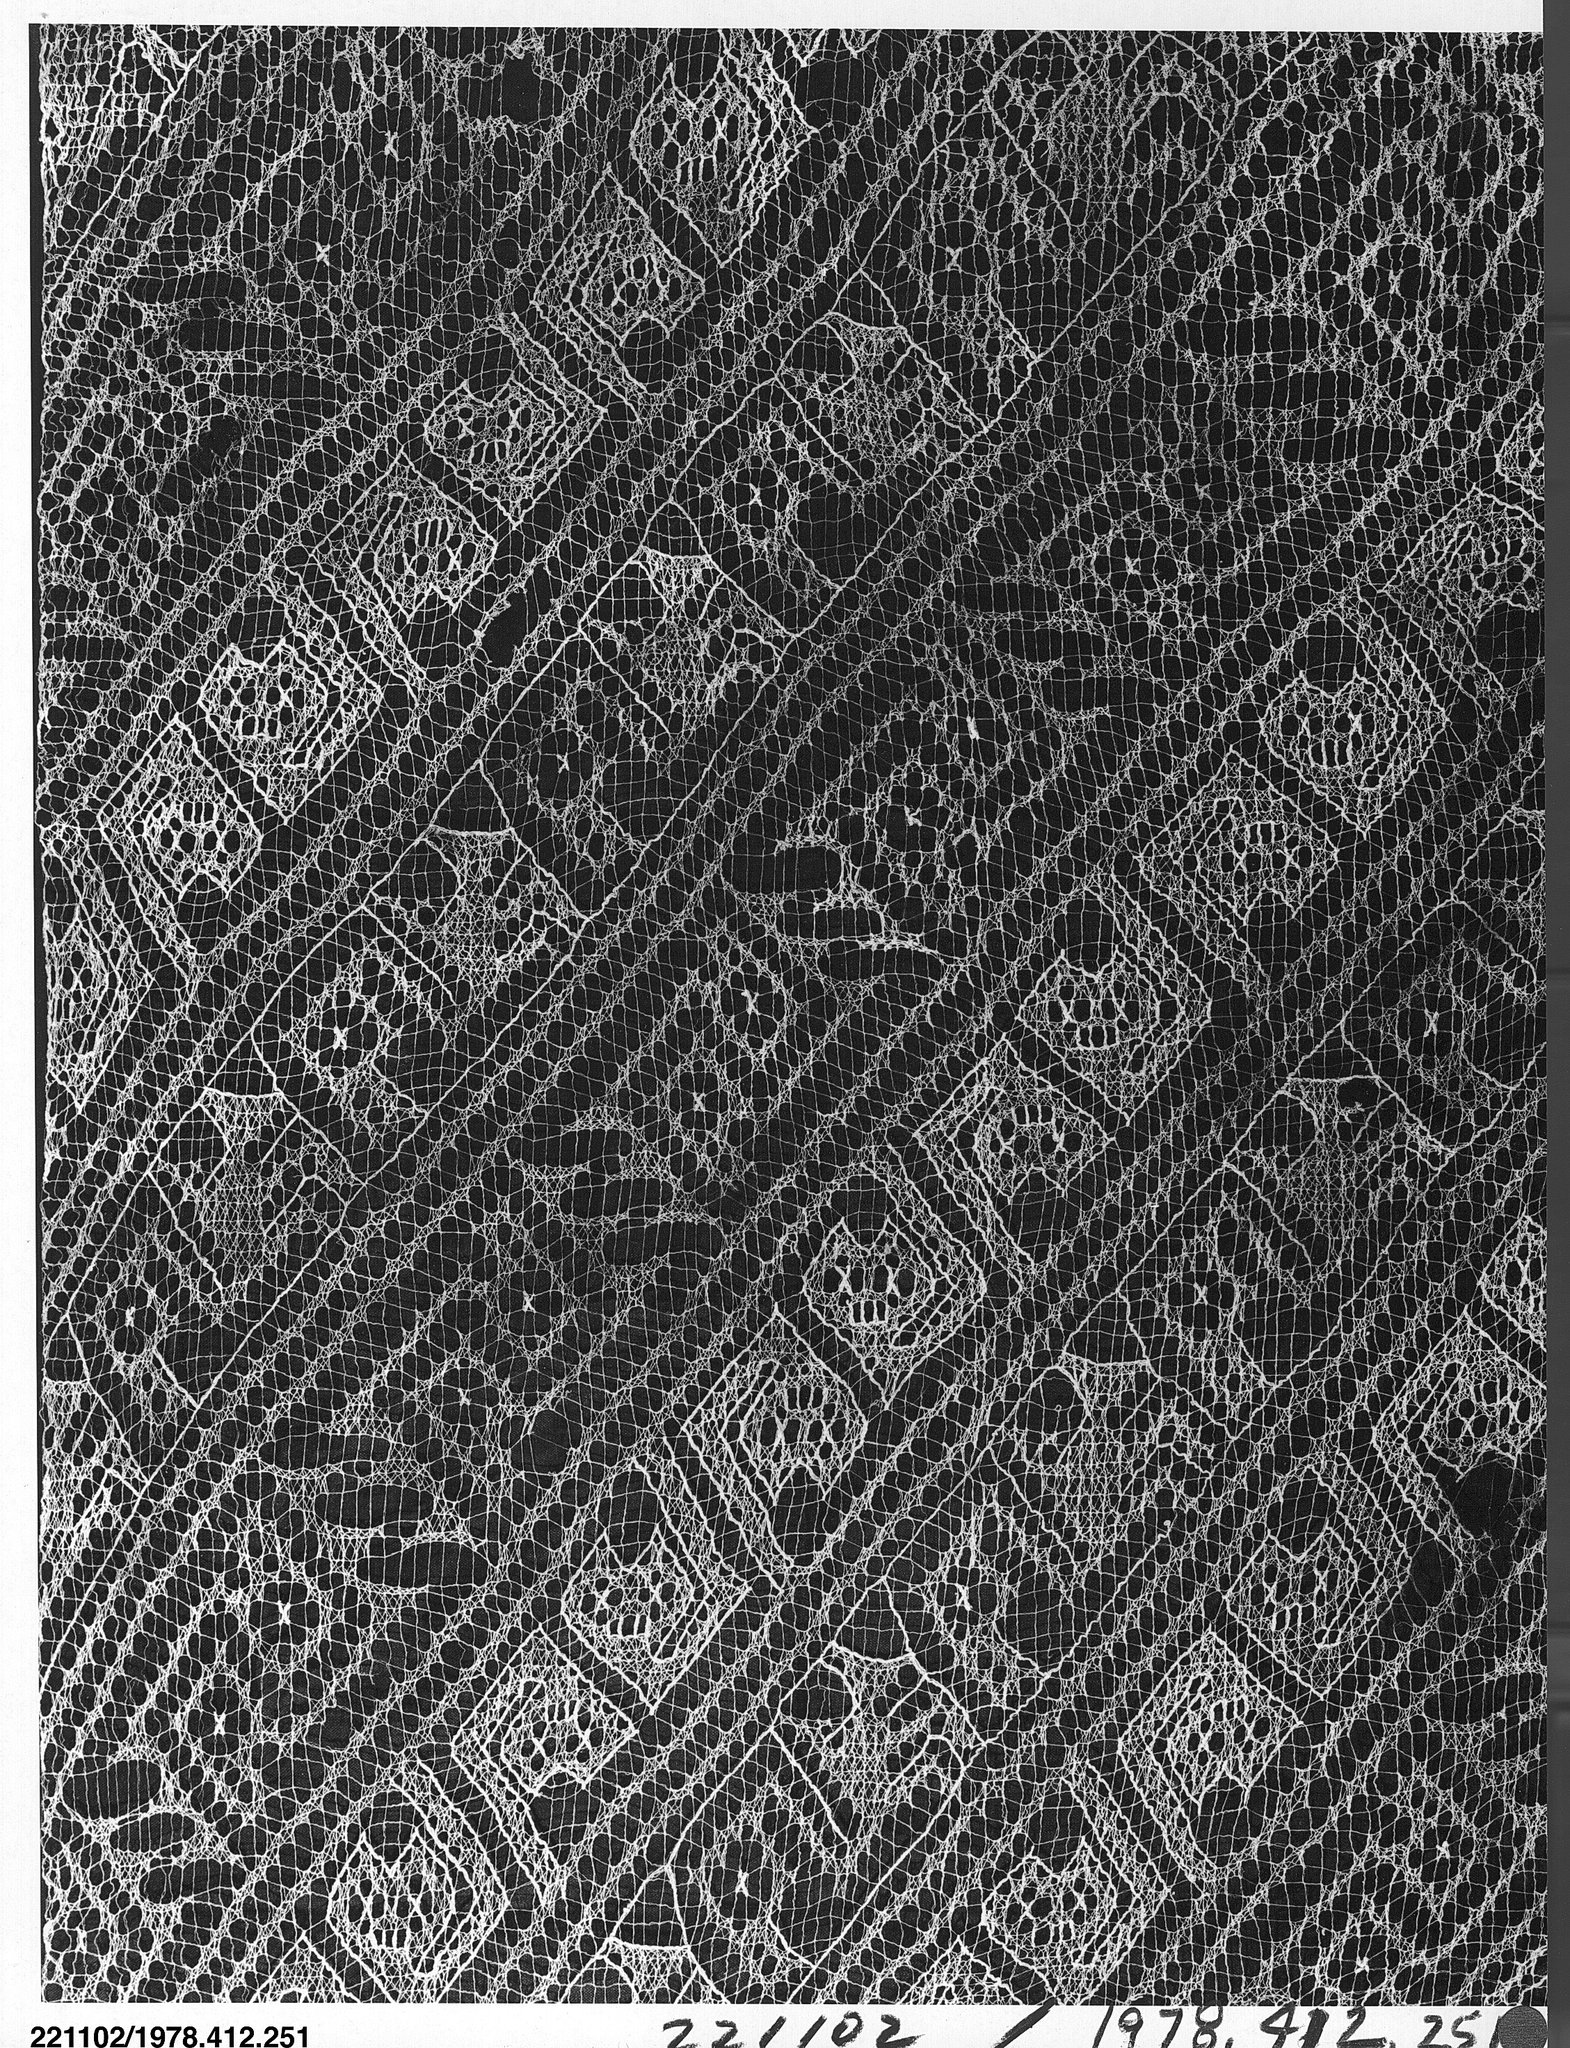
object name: headband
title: Openwork Headband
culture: chancay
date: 1101-1500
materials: cotton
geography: peru